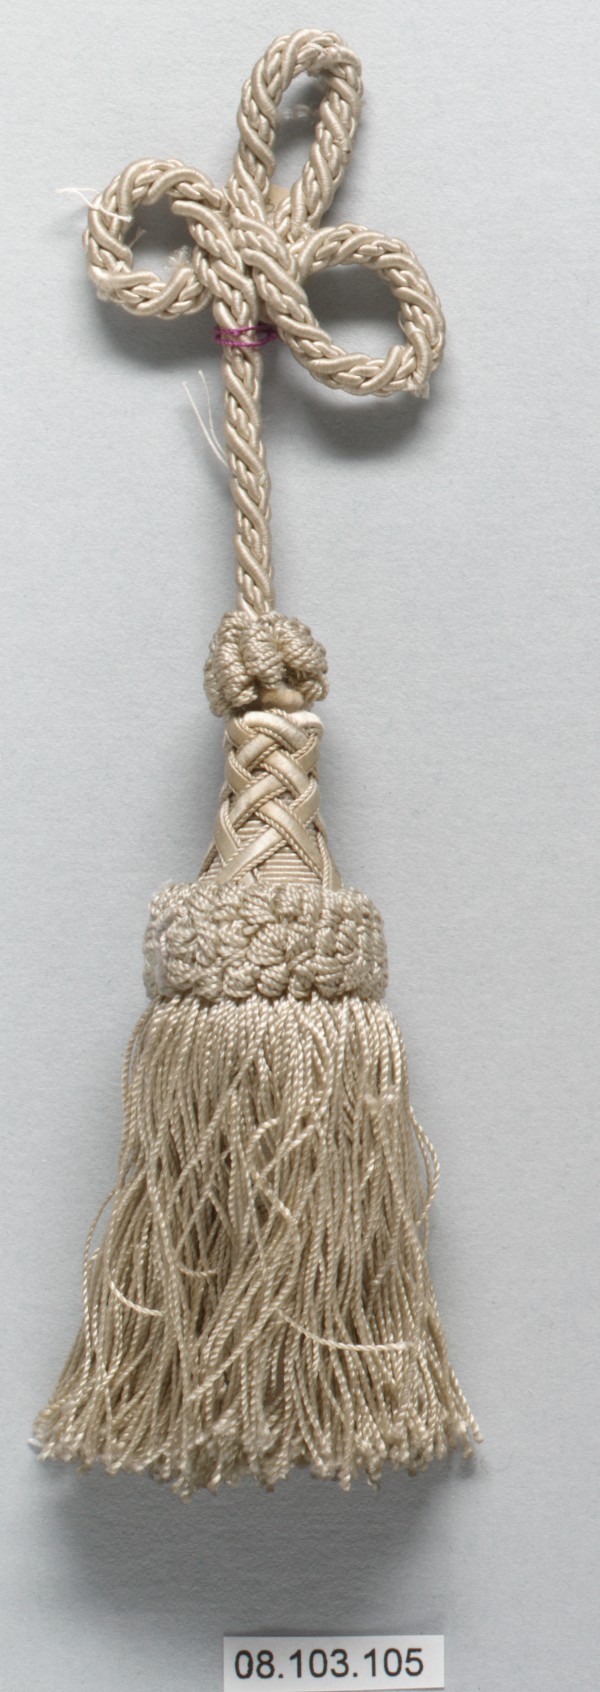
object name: tassel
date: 1801-1900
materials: silk